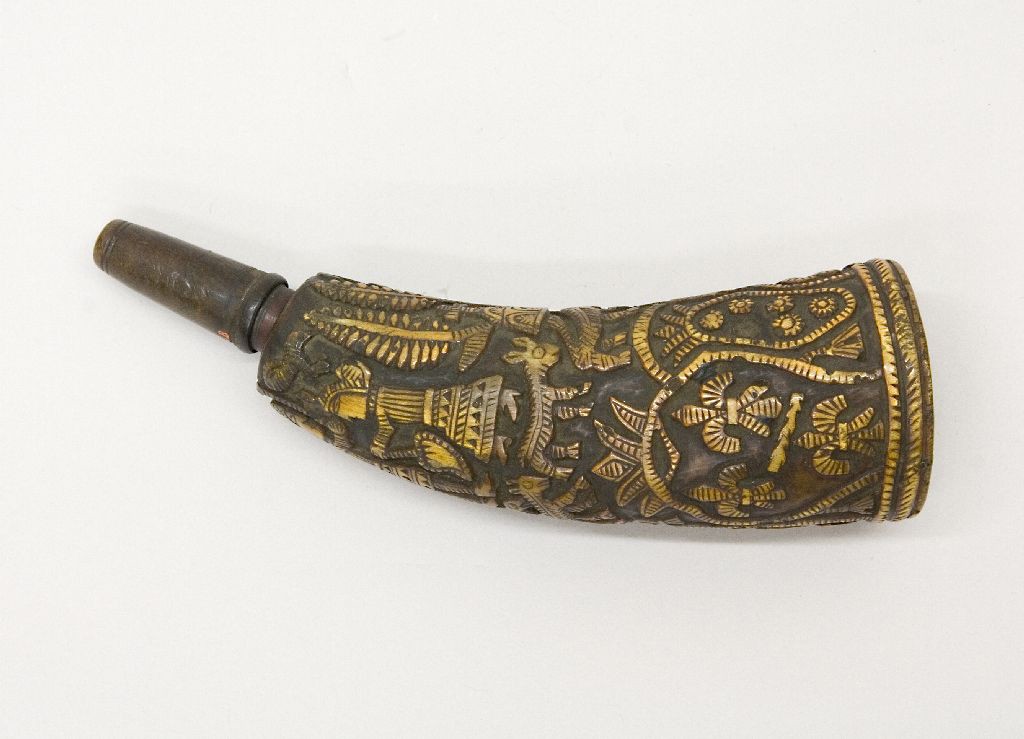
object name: powder flask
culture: scandinavian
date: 1601-1700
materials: horn